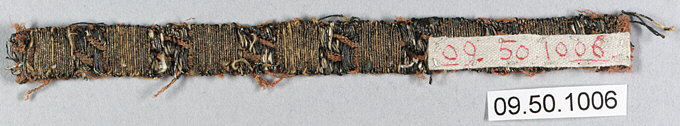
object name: gimp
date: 1701-1900